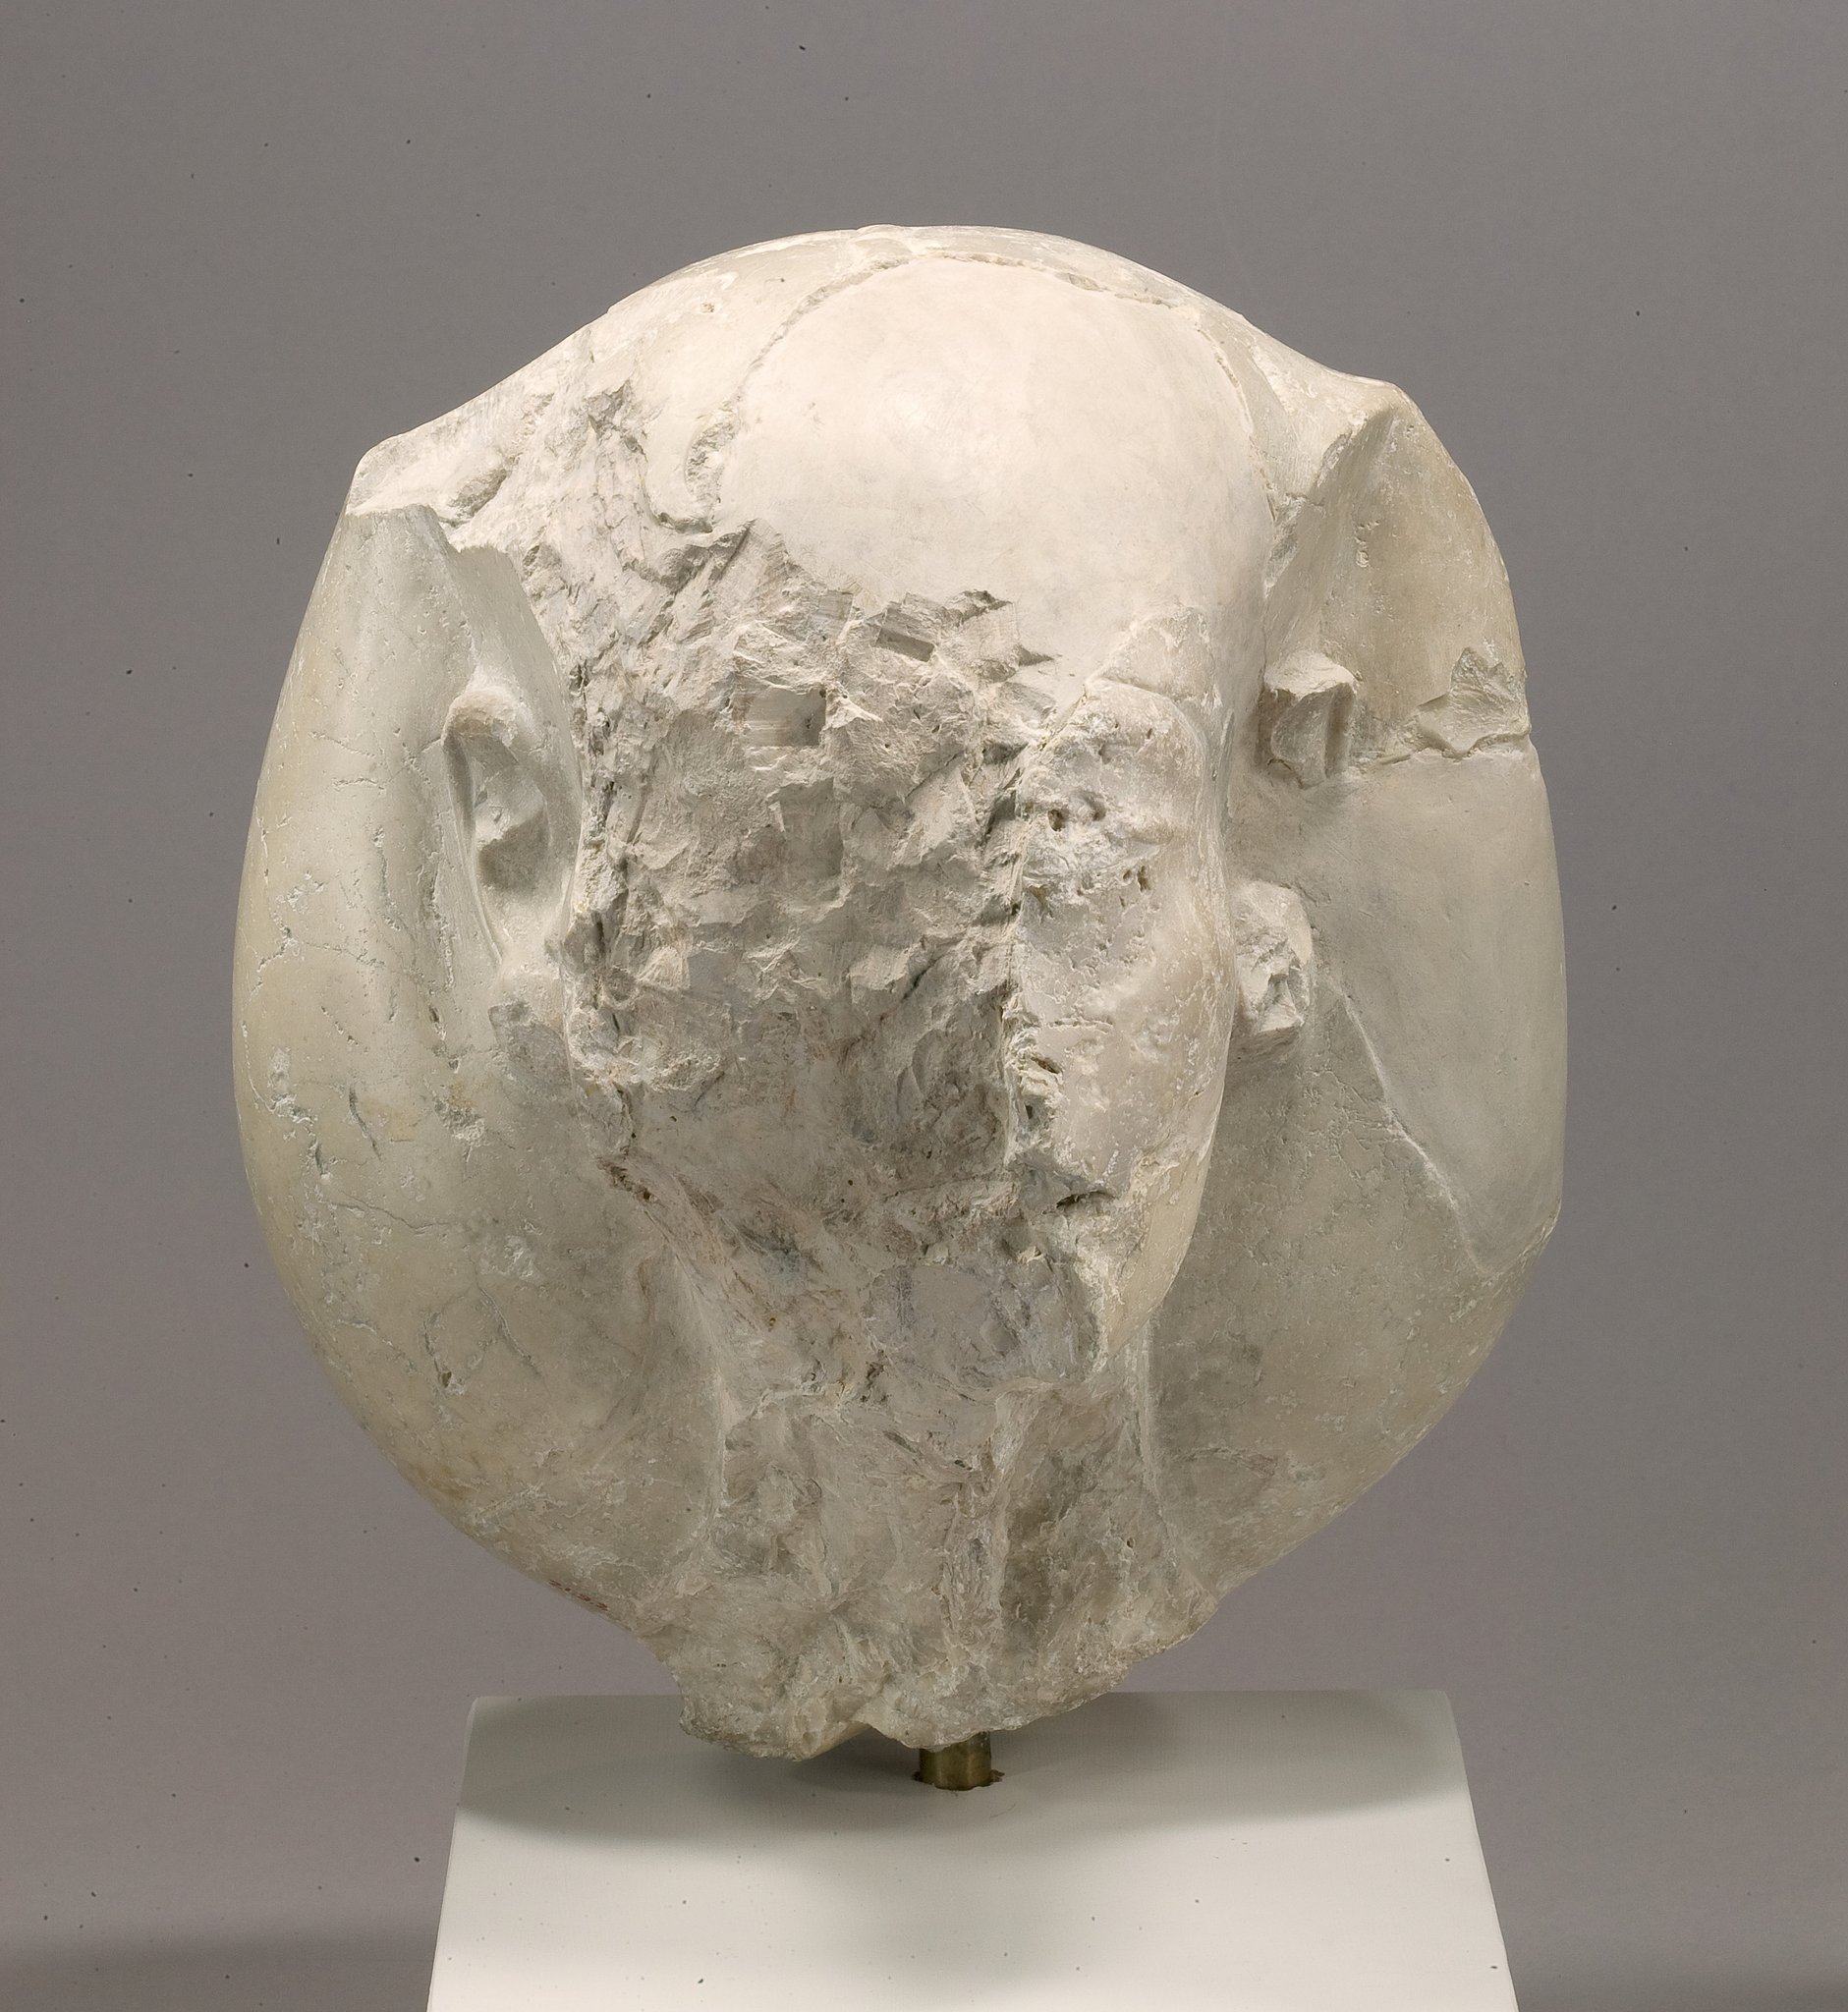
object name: head, royal, khat headdress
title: Head of king or queen in khat headdress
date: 1353-1336 BCE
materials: limestone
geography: egypt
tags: heads